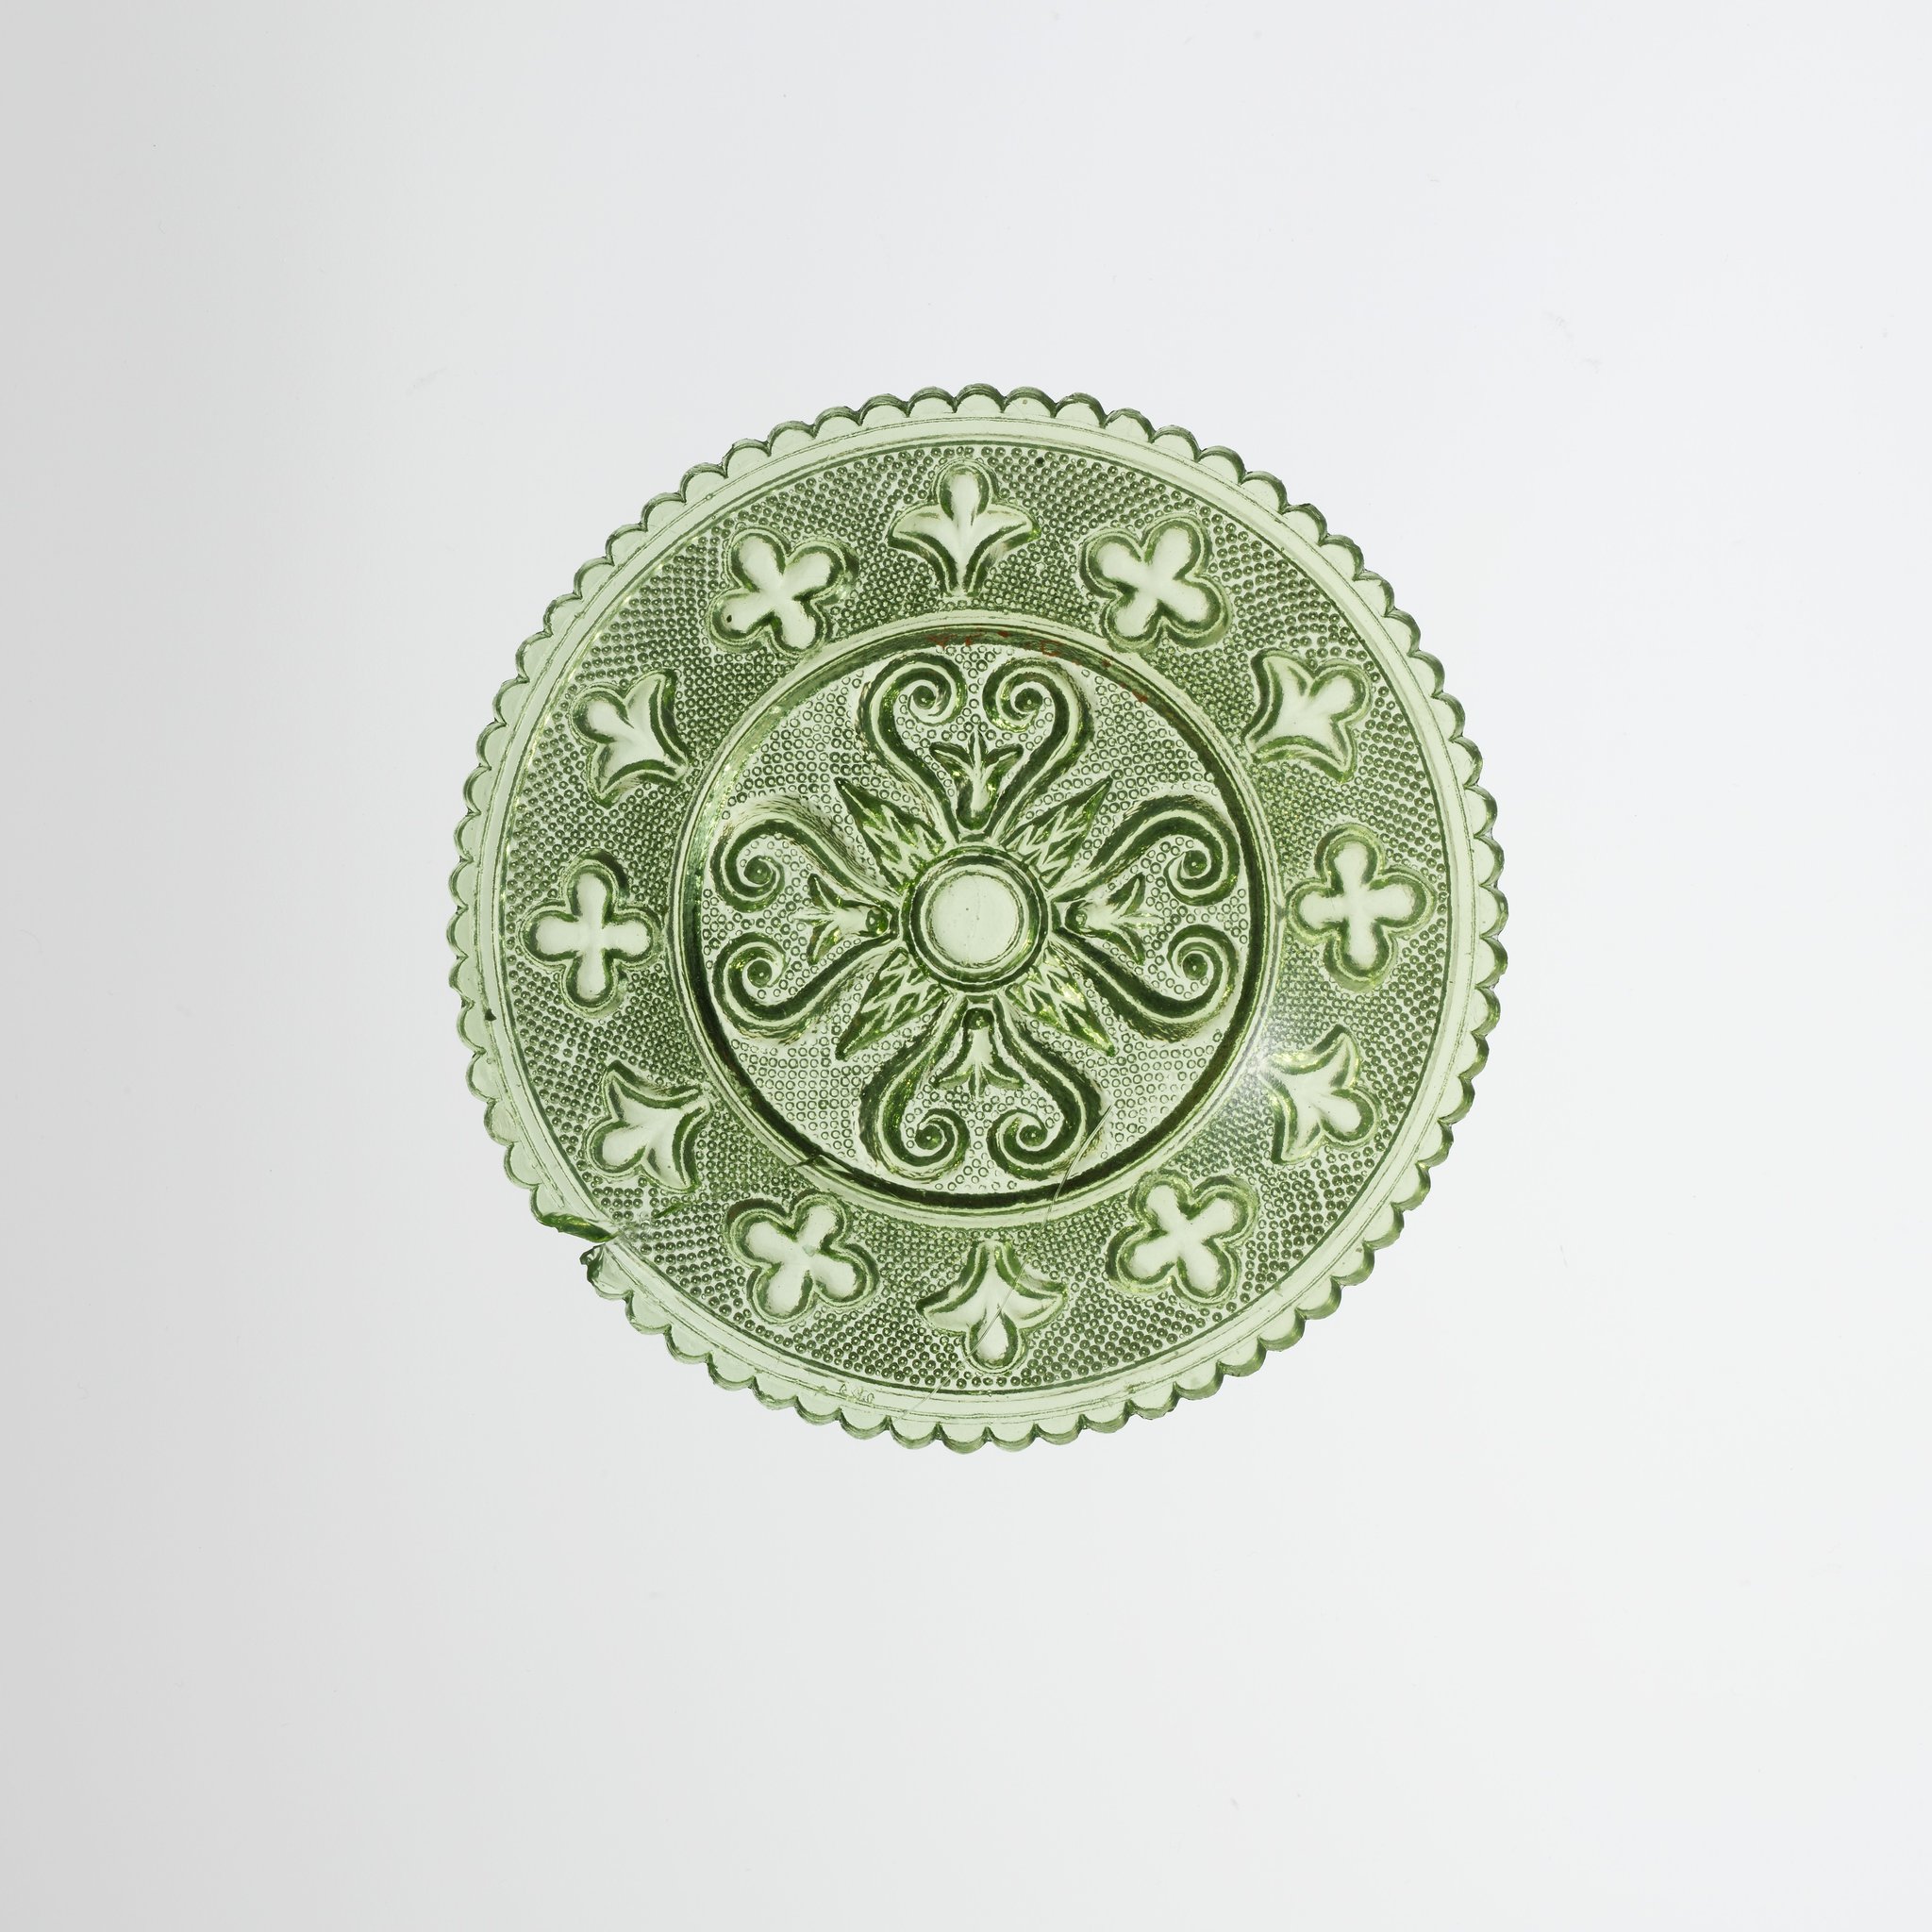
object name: cup plate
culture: american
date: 1825-1860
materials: glass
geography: united states